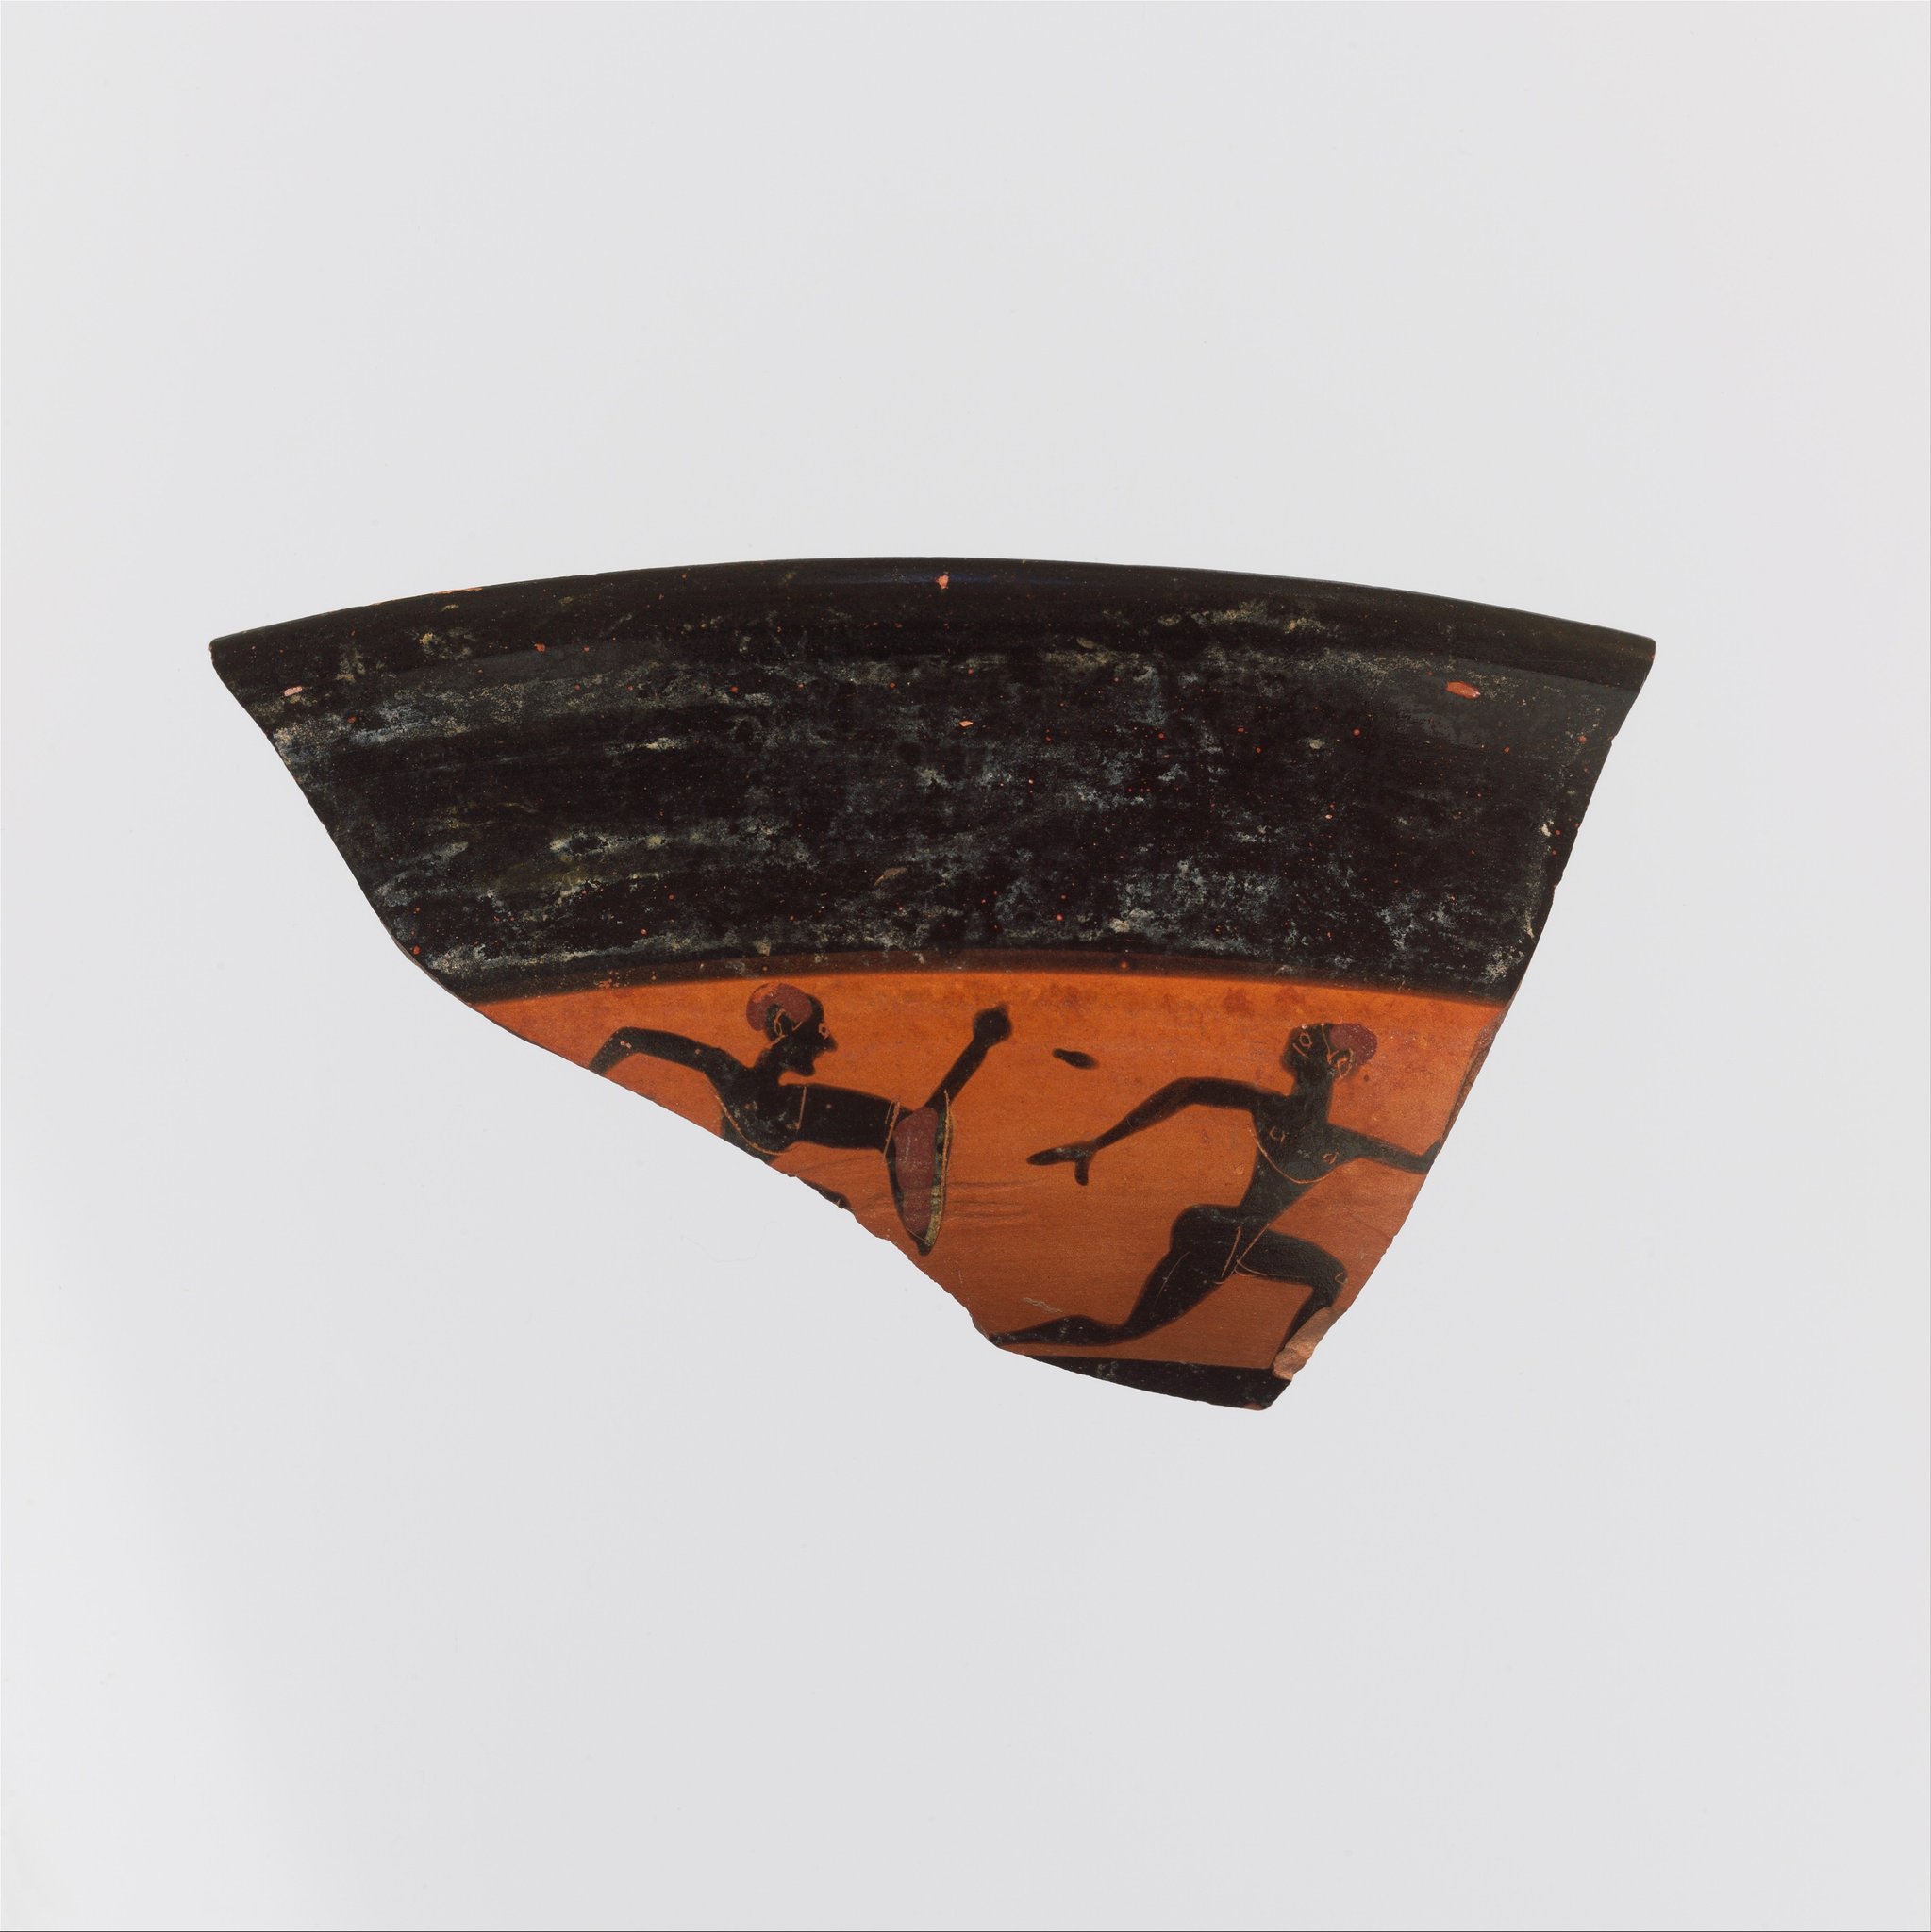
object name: kylix, band cup fragment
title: Fragment of a kylix: band-cup (drinking cup)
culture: greek, attic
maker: elbows out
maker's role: artist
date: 540 BCE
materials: terracotta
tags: human figures